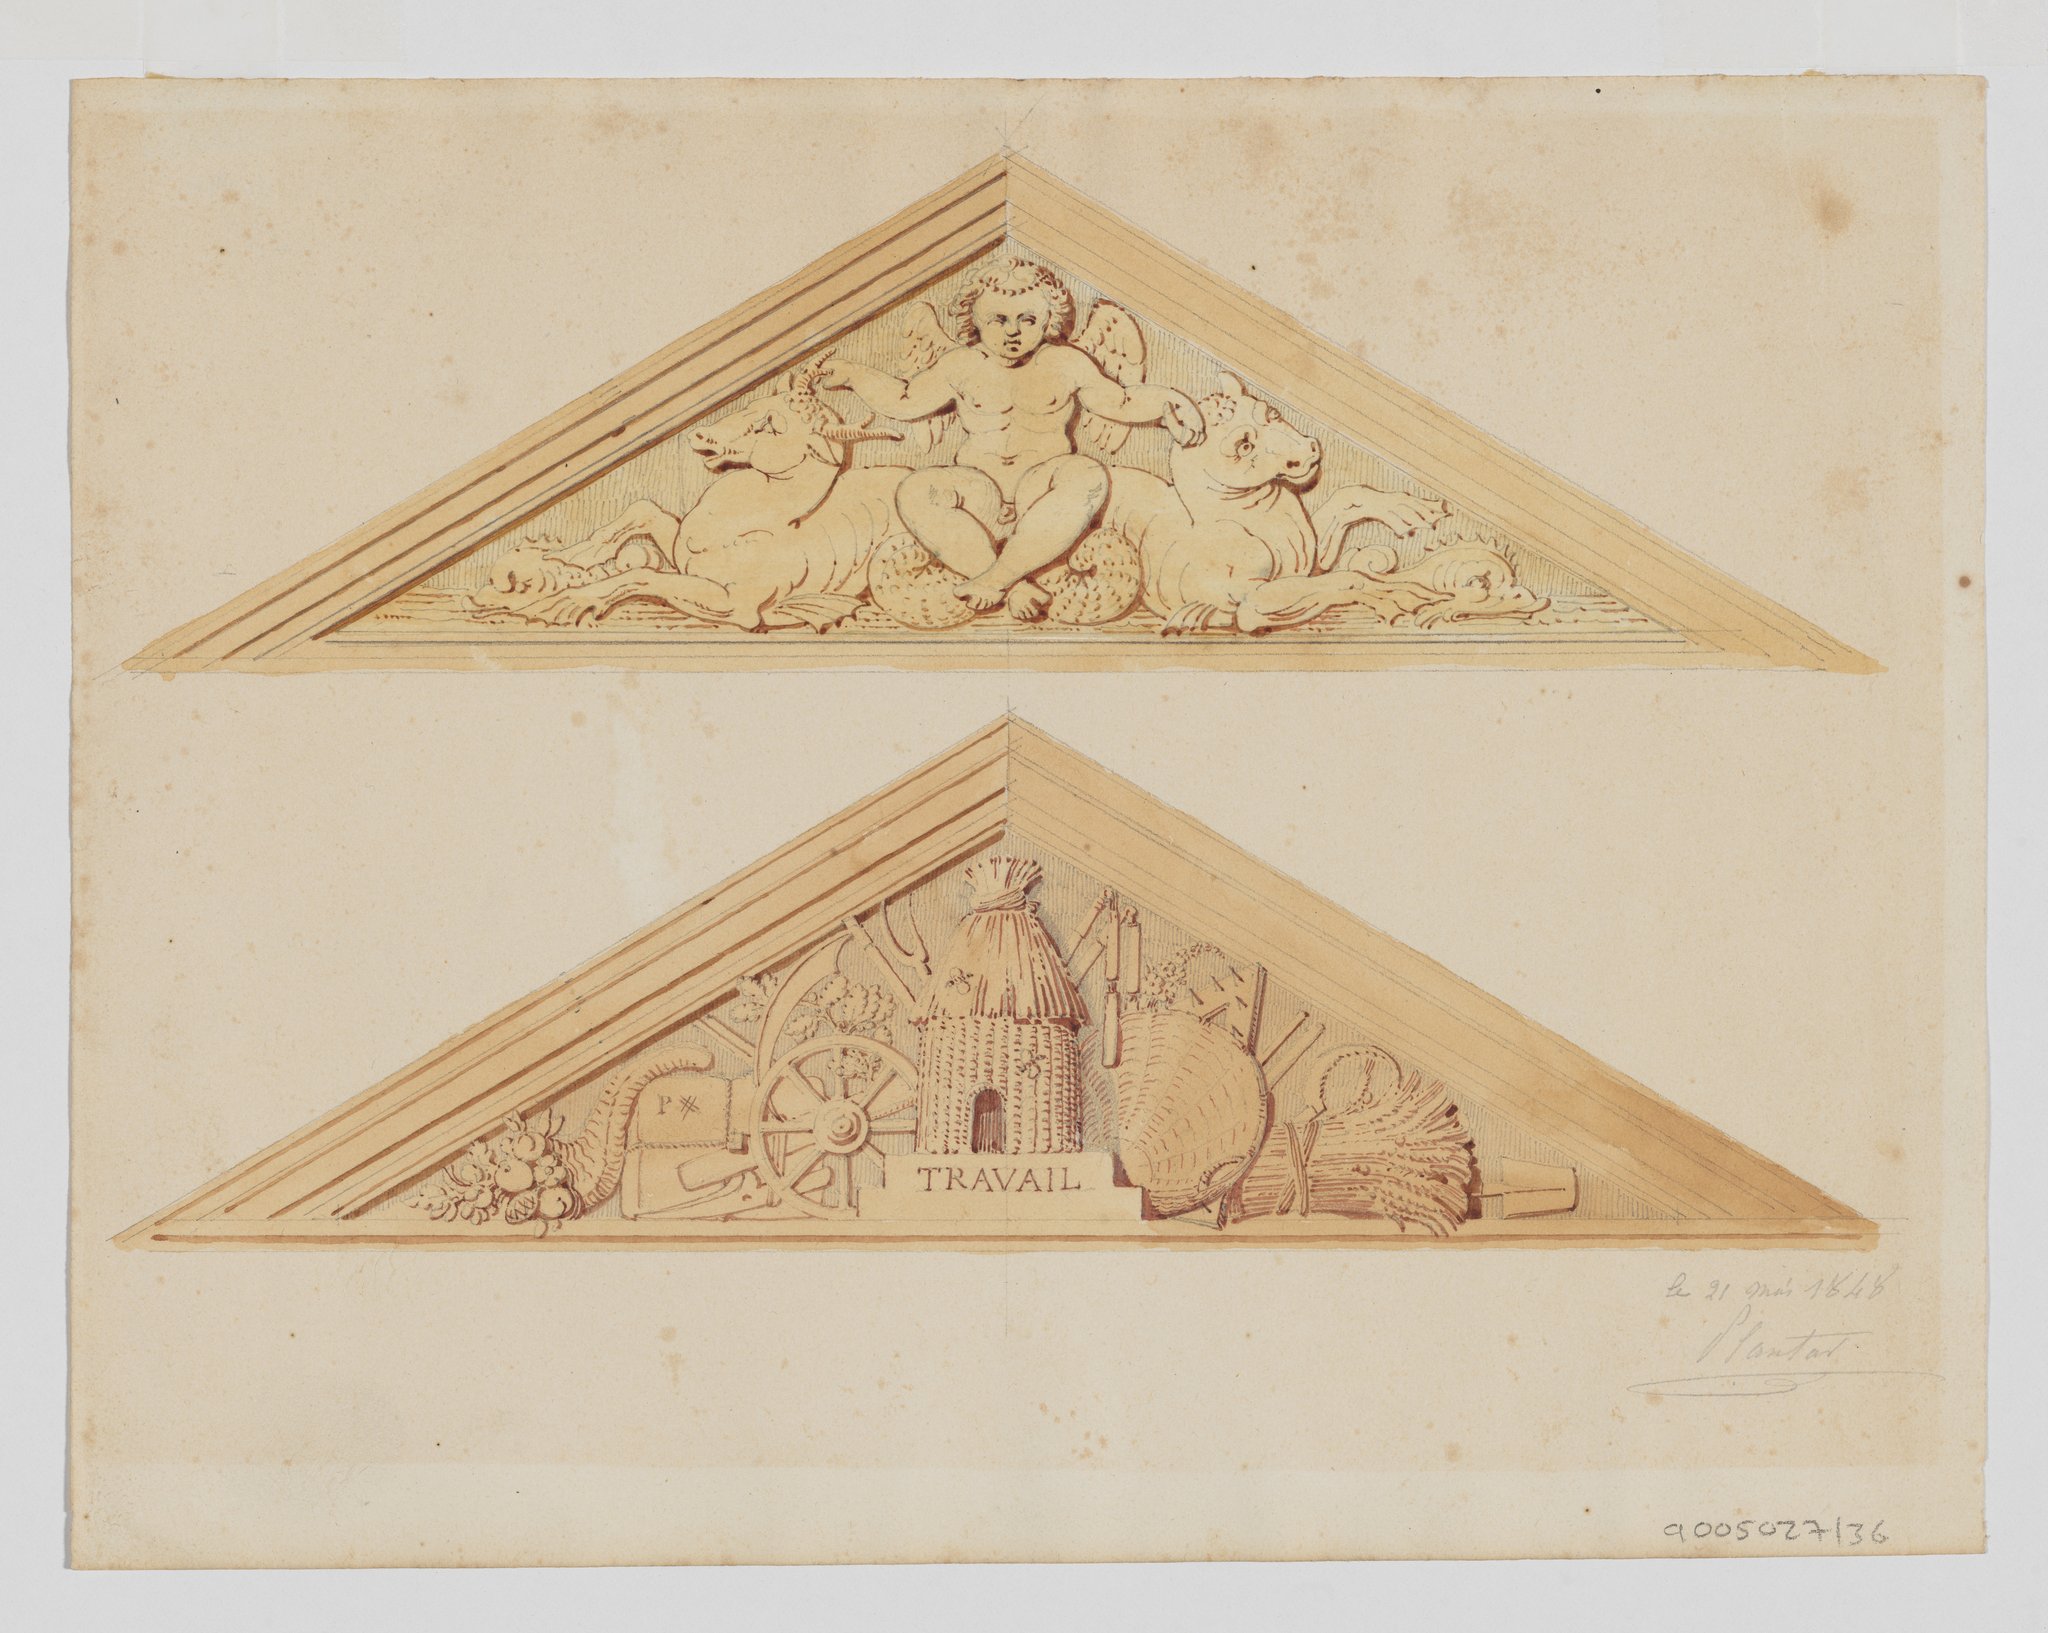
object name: drawing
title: Two Designs for Pediments, one with a Putto and Hybrid creatures, another dedicated to Labor (Travail)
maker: jean-baptiste louis plantar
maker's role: artist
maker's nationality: french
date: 1834-1866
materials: graphite, ink, watercolor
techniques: pen